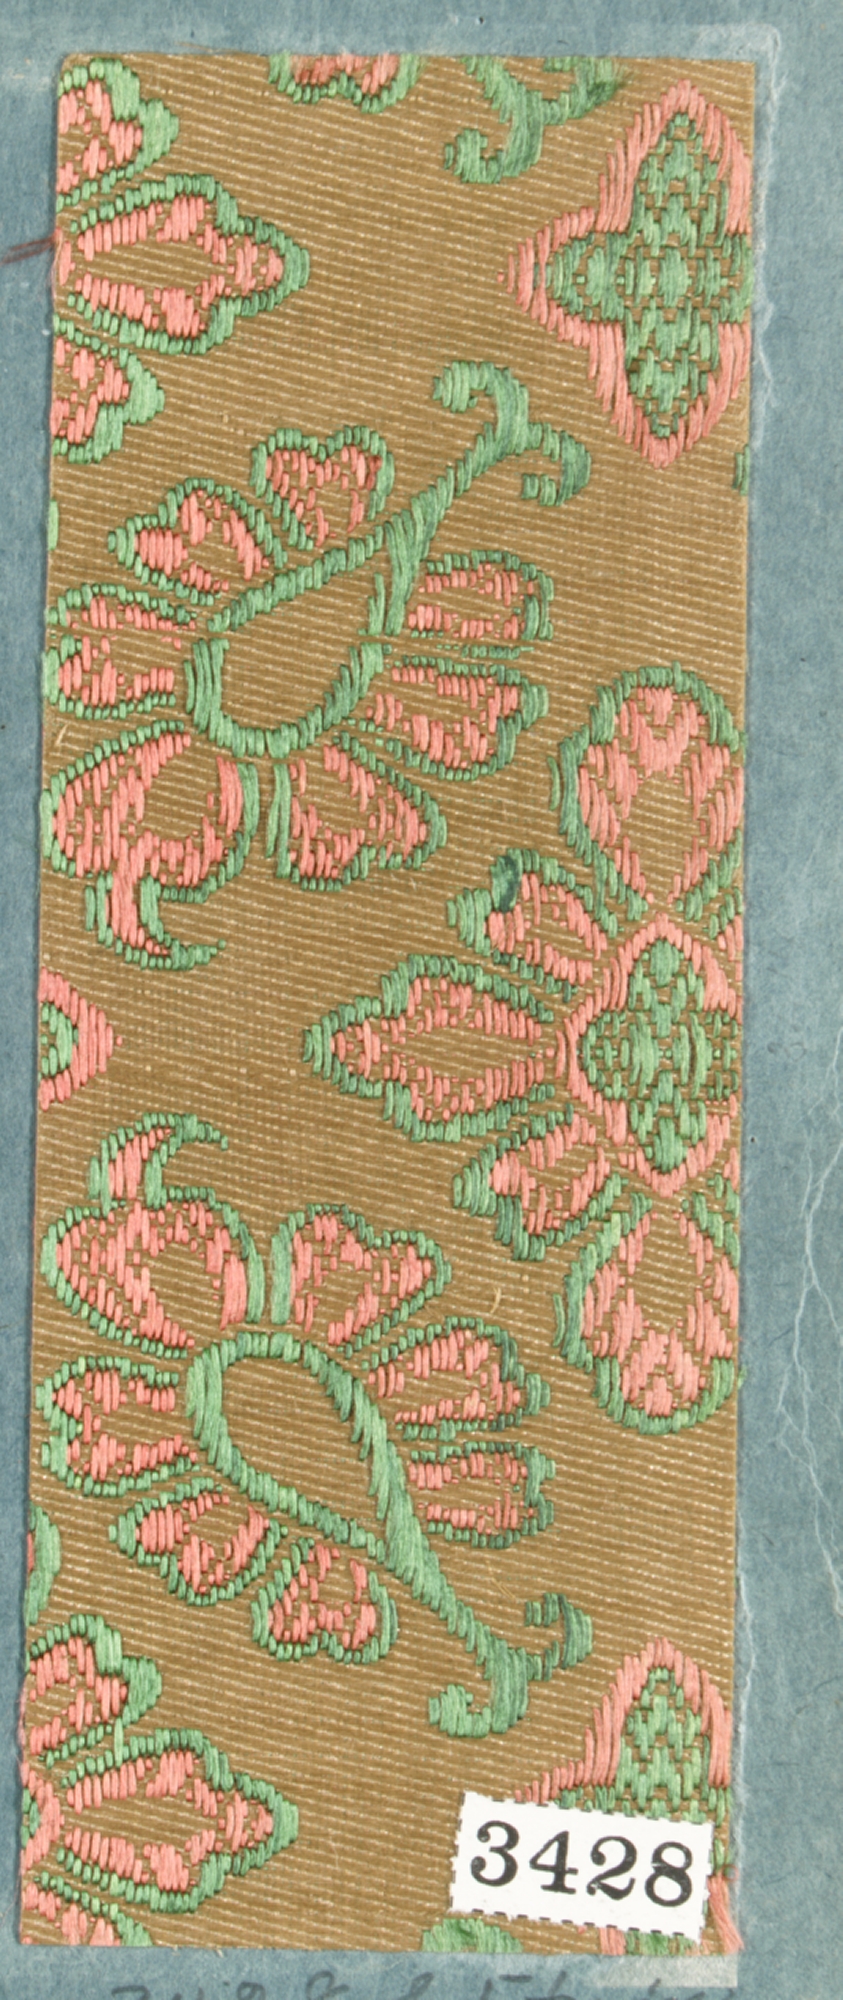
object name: textile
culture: japanese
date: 1801-1900